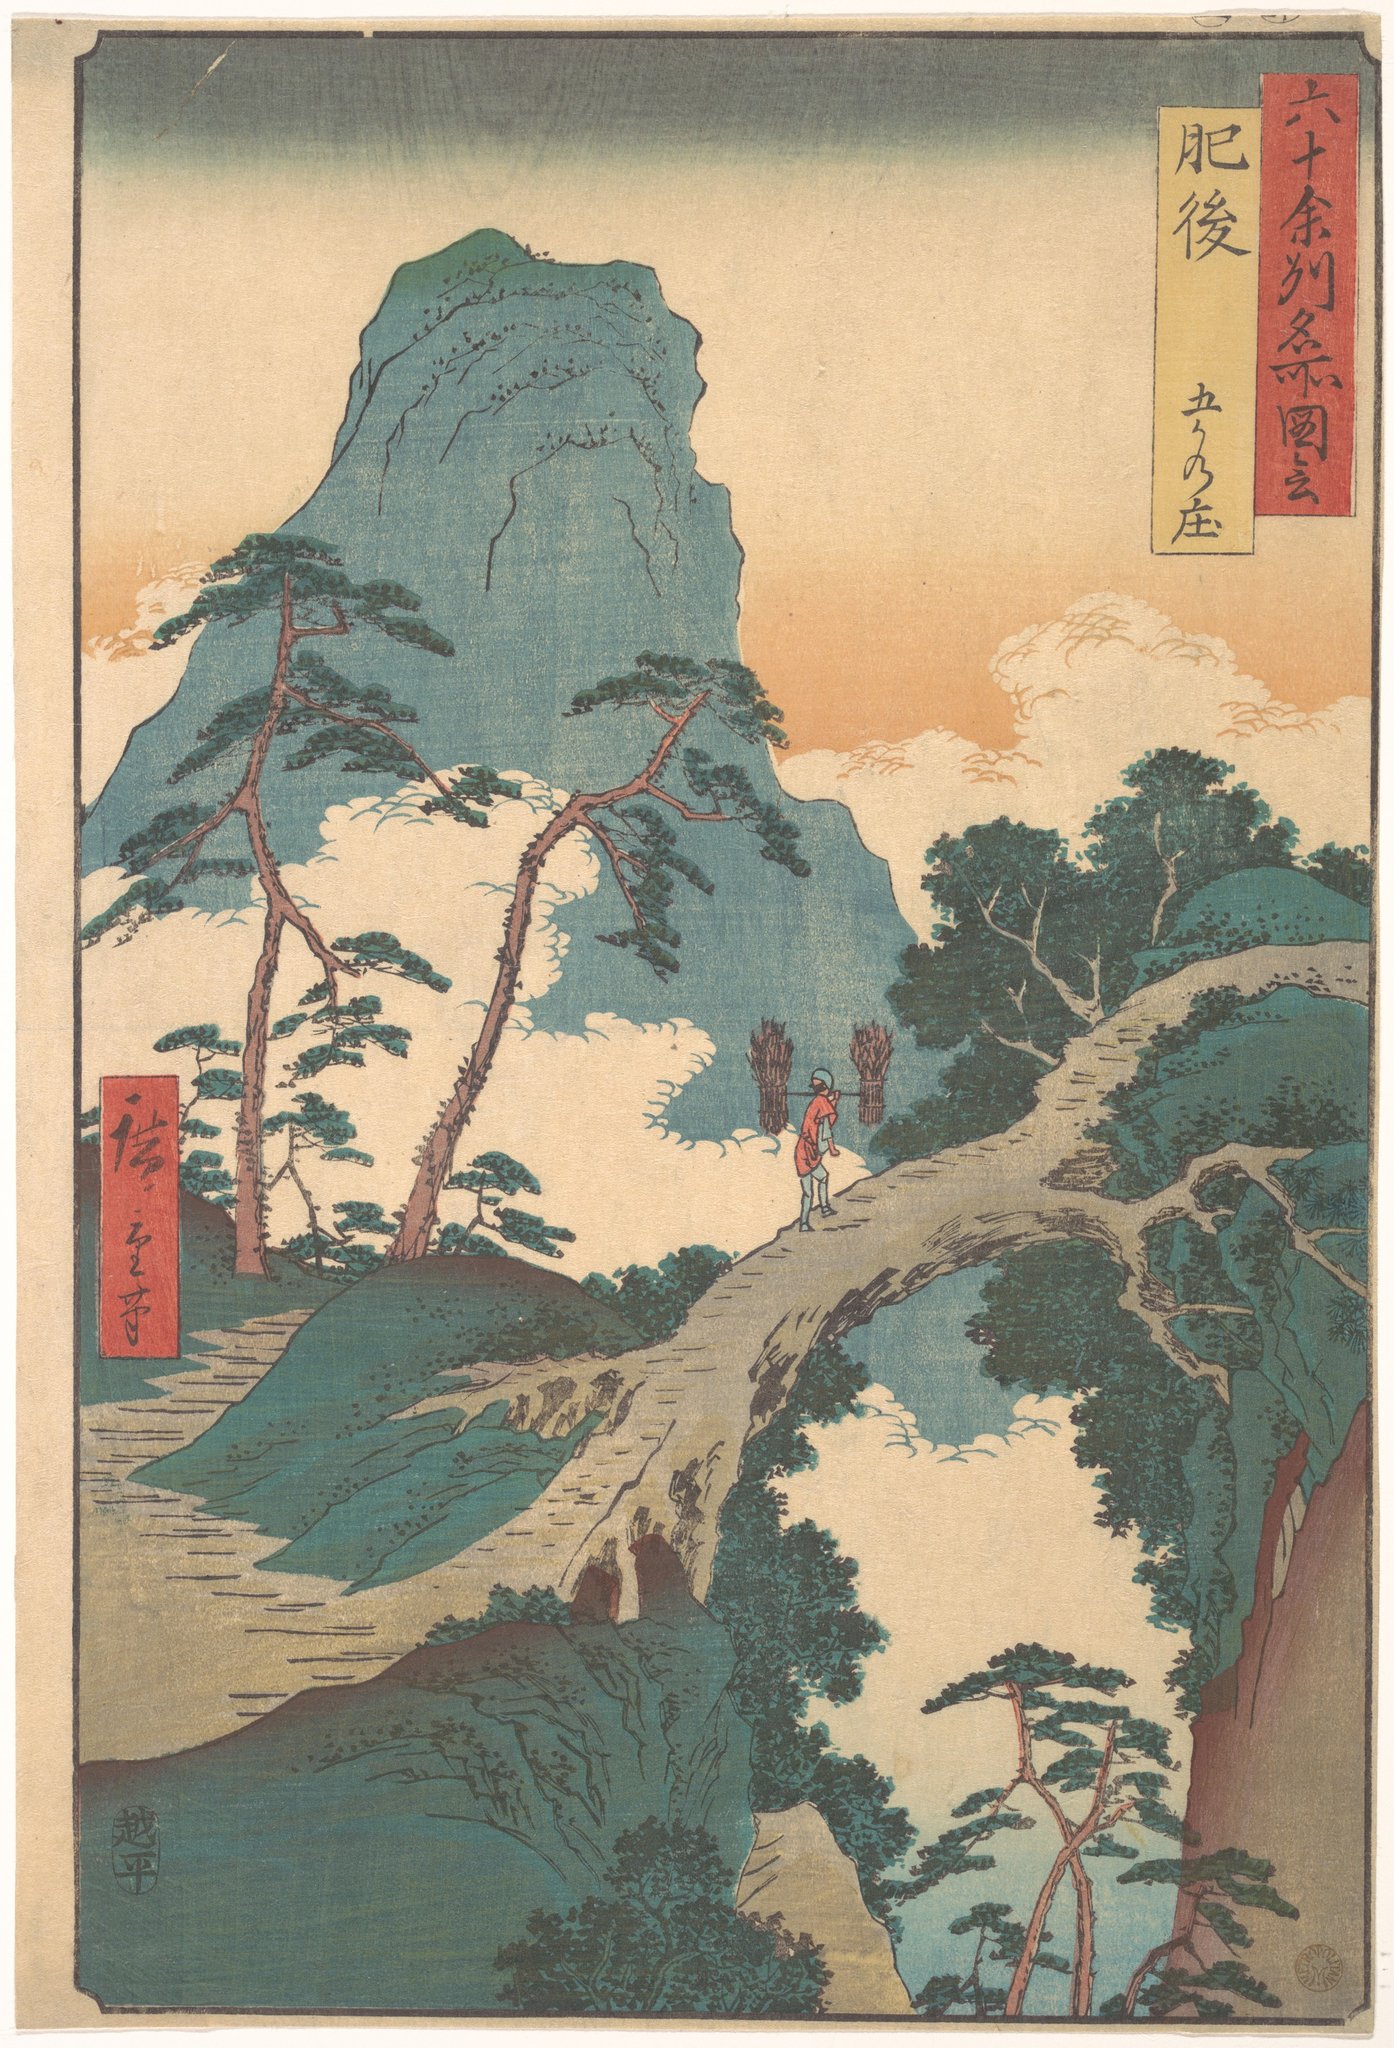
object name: print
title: Goka no Shō, Higo Province, from the series Views of Famous Places in the Sixty-Odd Provinces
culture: japanese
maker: utagawa hiroshige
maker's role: artist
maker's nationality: japanese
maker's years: 1797-1858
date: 1853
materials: ink, paper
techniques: woodblock print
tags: men,mountains,trees